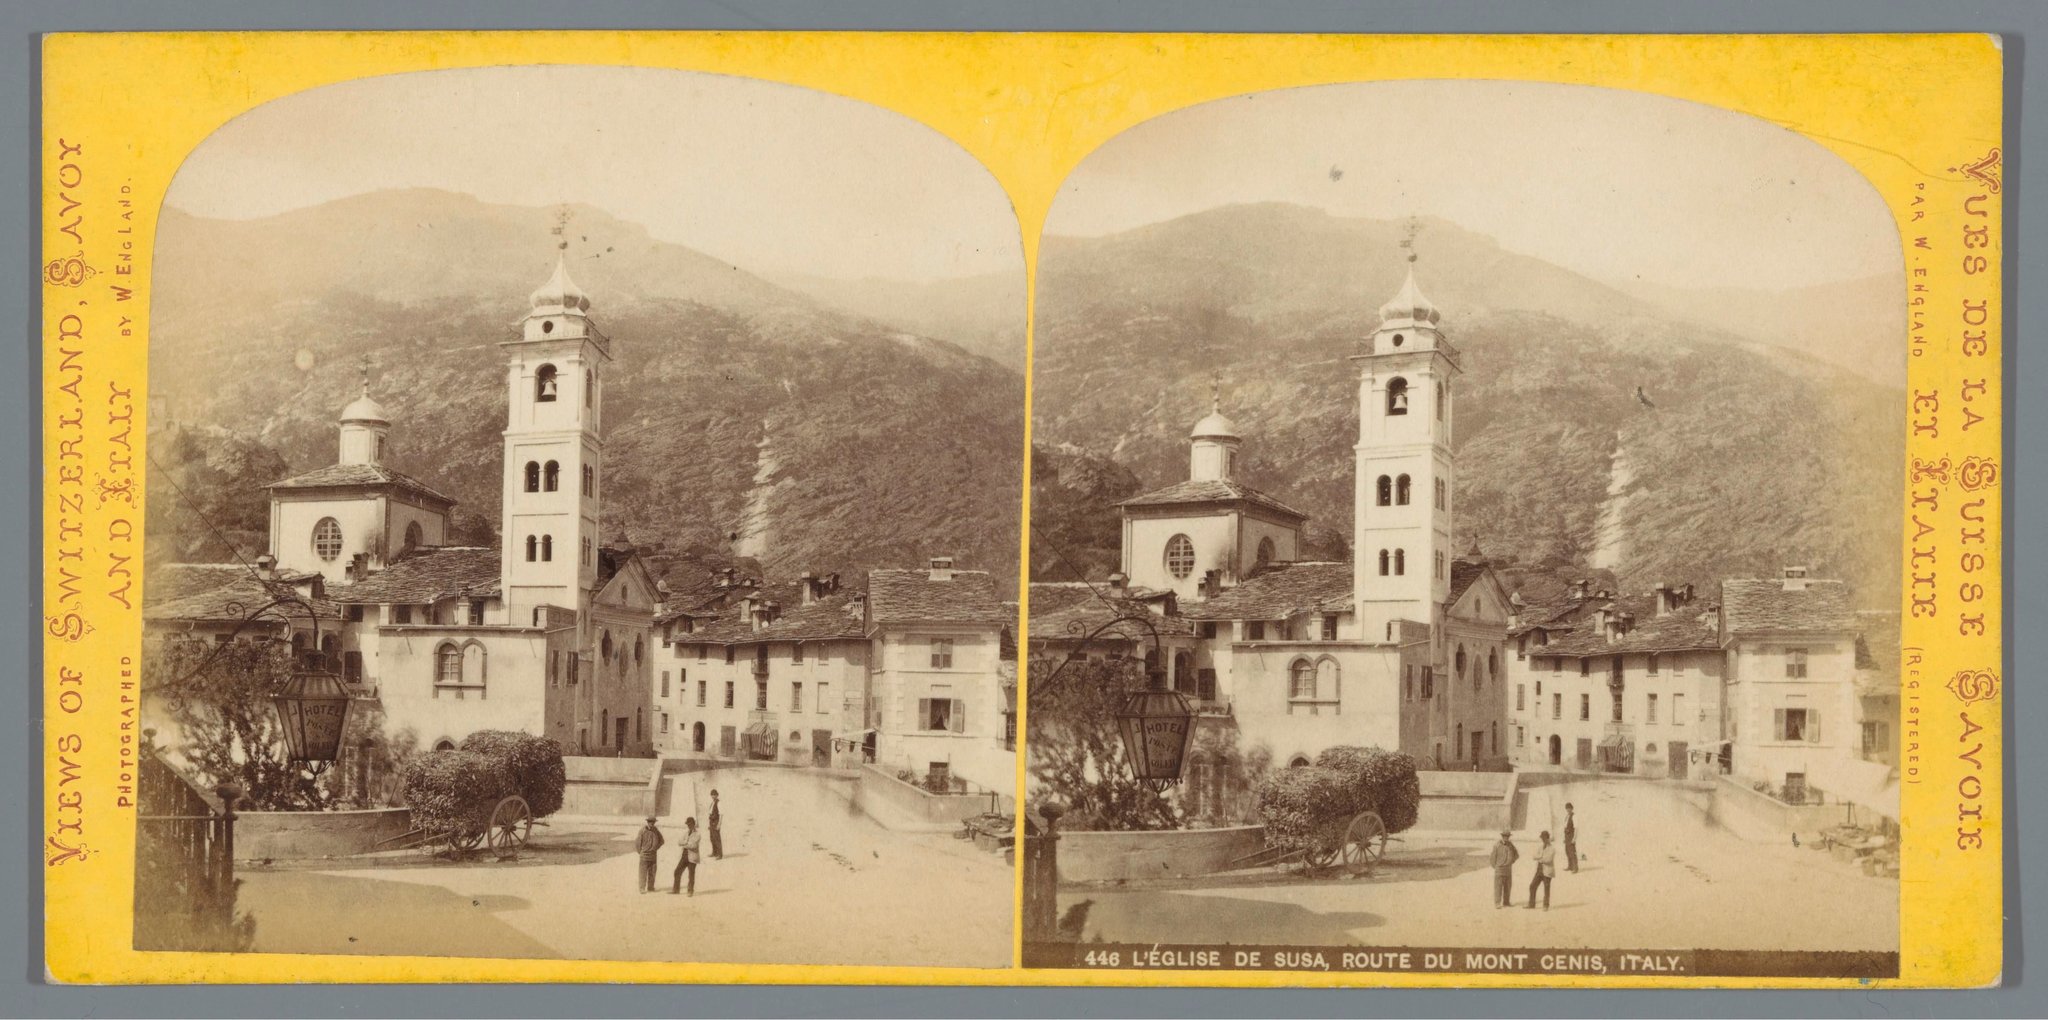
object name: stereograph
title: Gezicht op de Chiesa del Ponte in Susa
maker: william england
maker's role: fotograaf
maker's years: 1816-1896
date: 1850-1880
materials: cardboard, photographic support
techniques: albumen print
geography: susa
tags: church (exterior), mountains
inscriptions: inscription: ‘Vues de la Suisse Savoie et Italie’, number: ‘446’